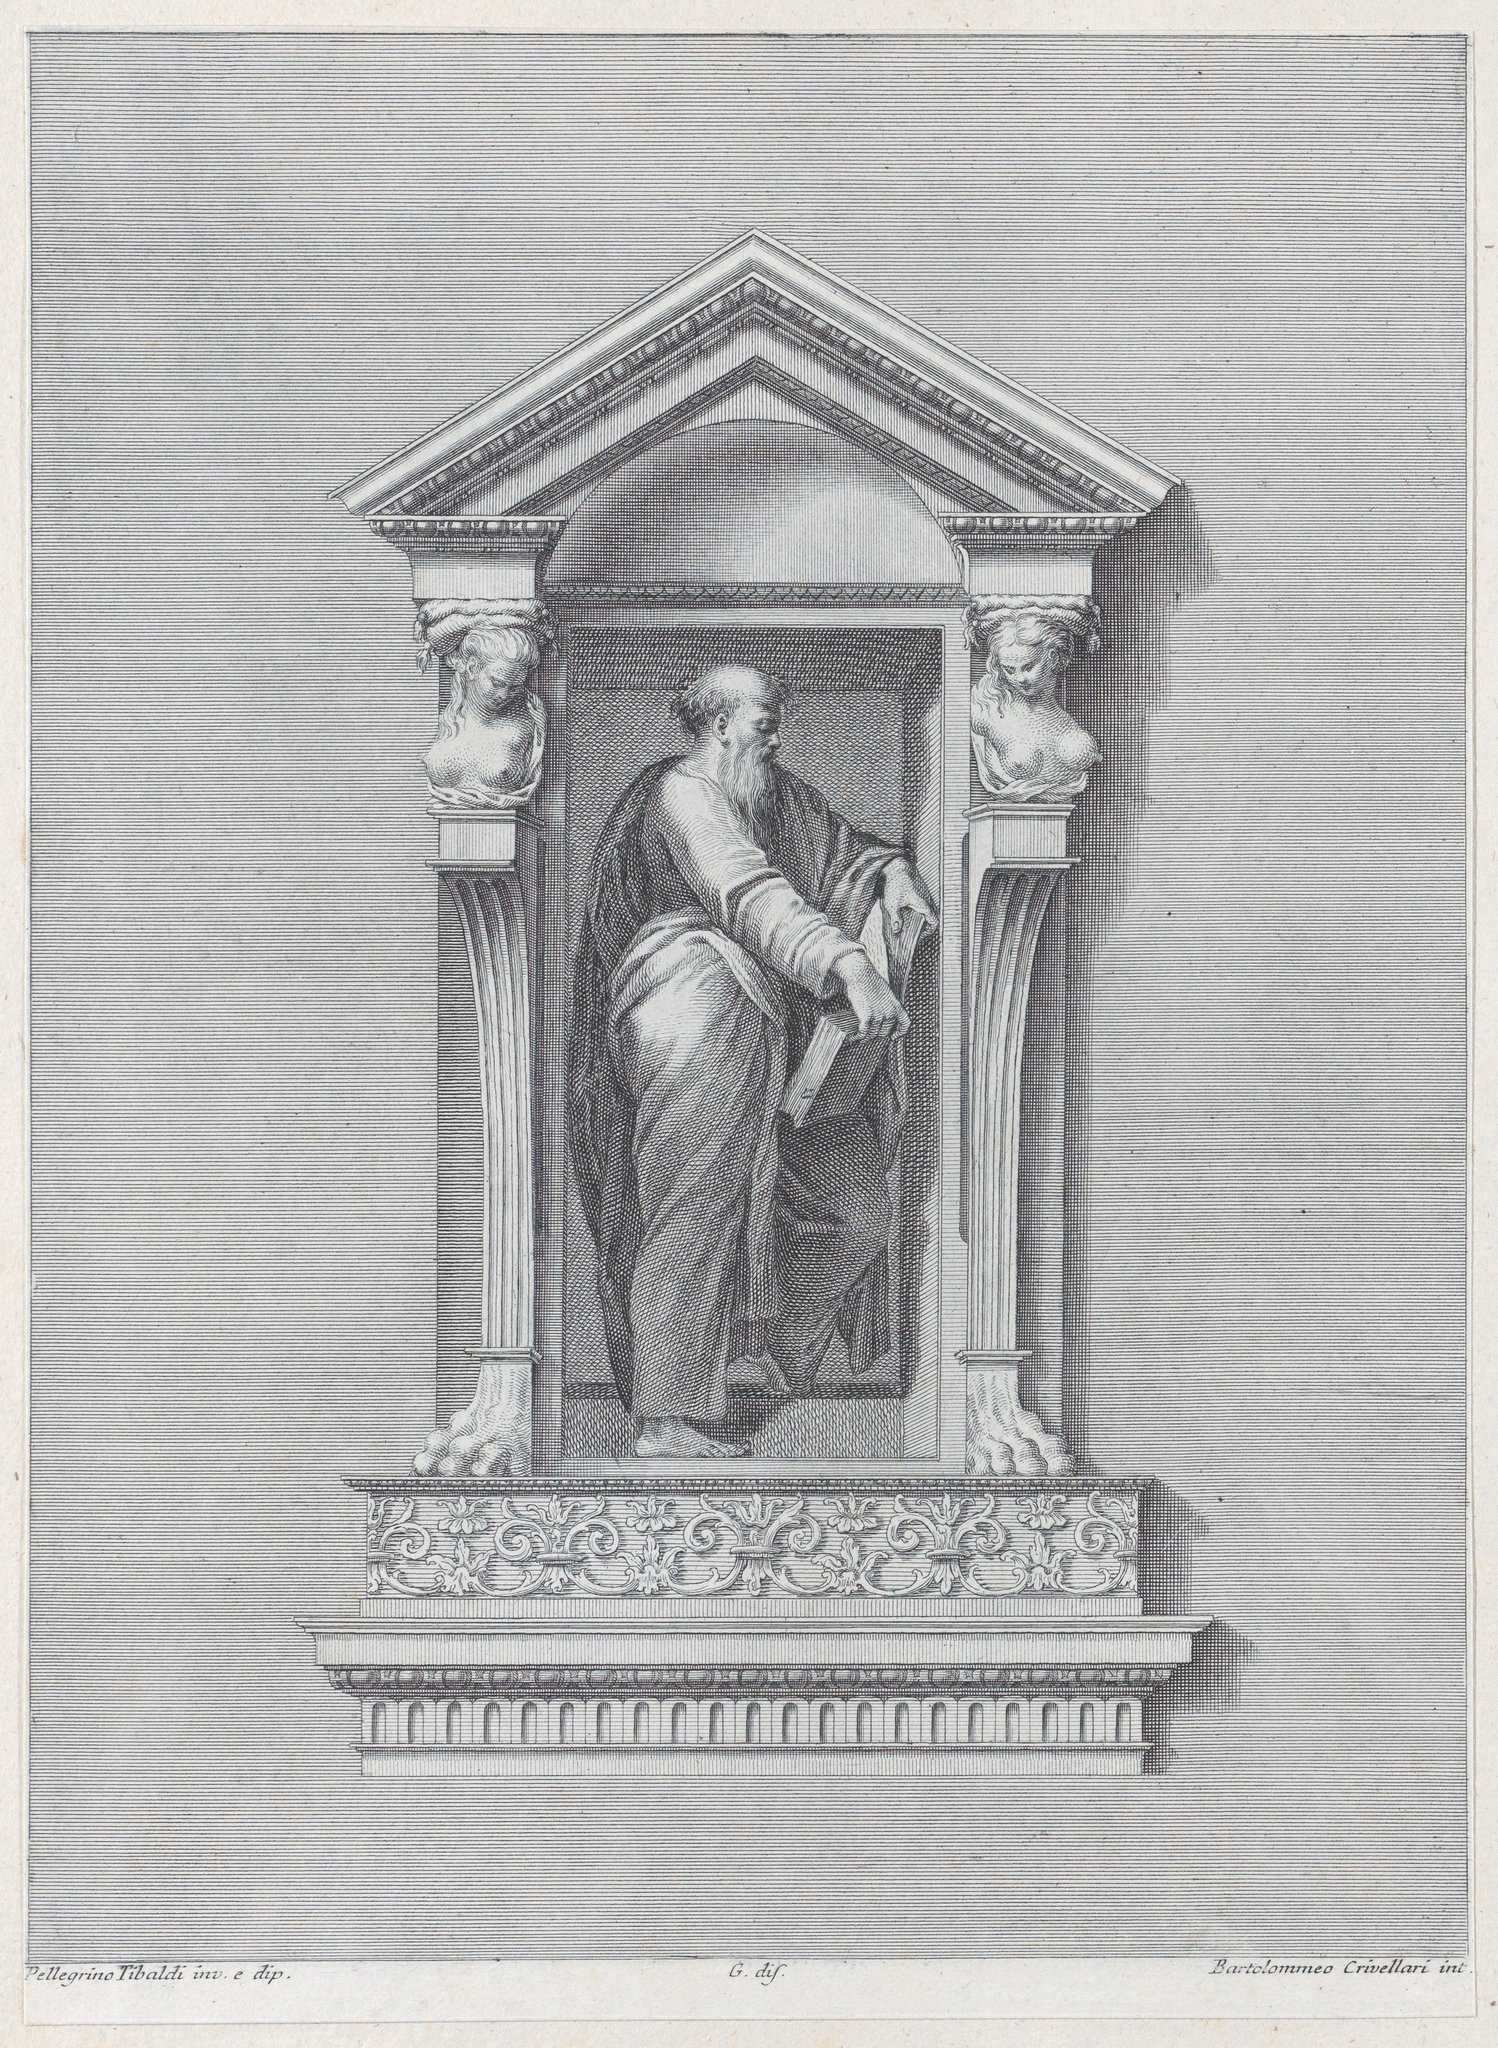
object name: print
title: A standing man in a niche holding an open book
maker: bartolomeo crivellari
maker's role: artist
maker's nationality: italian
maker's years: 1700-1800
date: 1756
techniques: engraving, etching